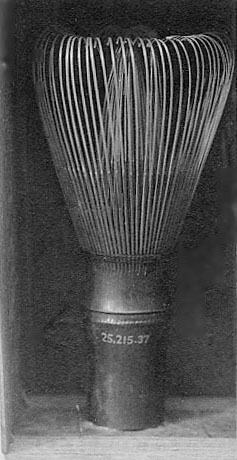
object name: whisk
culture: japanese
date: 1868-1925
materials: bamboo